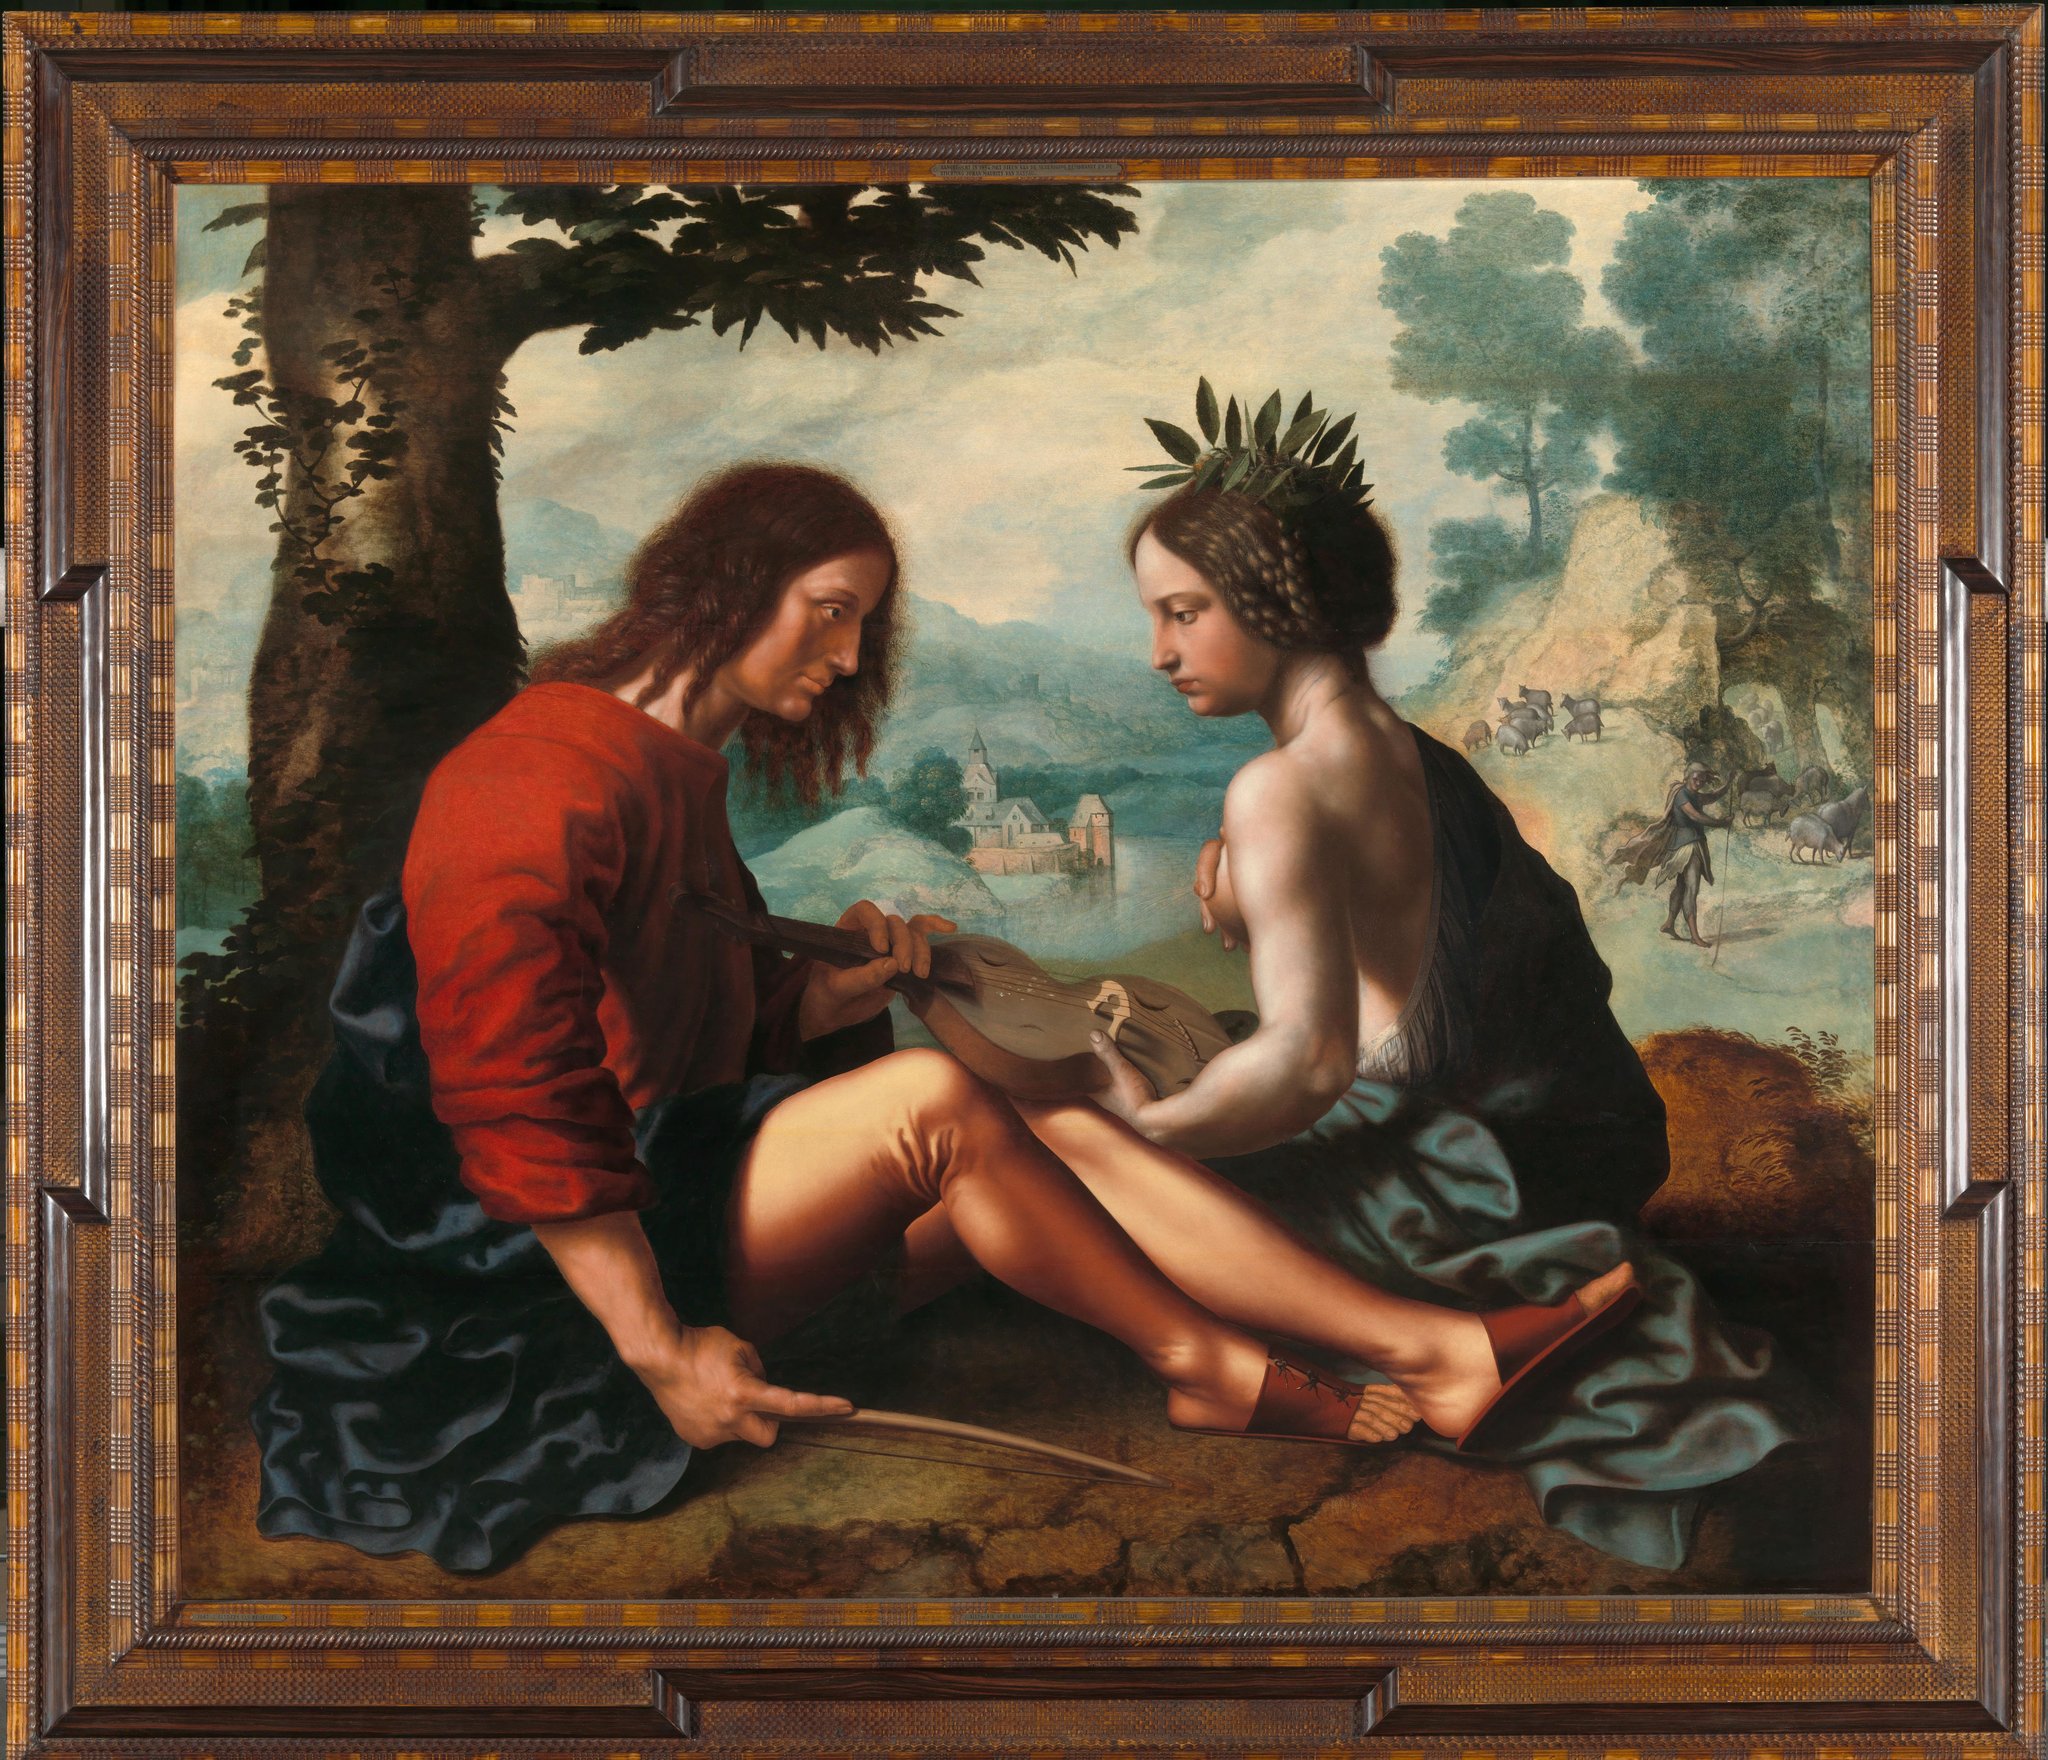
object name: painting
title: Allegory (Nature as the Nursemaid of Art)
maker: jan van hemessen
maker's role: painter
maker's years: 1500-1575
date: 1540-1557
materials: oil, panel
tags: 'natura' (allegorical figure or scene; or as diana of ephesus, with many breasts); 'natura' (ripa), breasts giving milk - aa - female human figure, 'musica', symbolic representations, allegories and emblems ~ music; 'musica'(ripa), viola, violoncello; double bass - cc - out of doors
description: A partially nude woman sprinkles milk from her breast on a man’s viol. This enigmatic scene may represent Mother Nature, who inspires and nourishes Art. Van Hemessen was a leading Antwerp painter in the second quarter of the 16th century. His figures betray a marked Italian influence, especially in his use of soft, ‘smoky’ contours, the so-called sfumato painting technique.